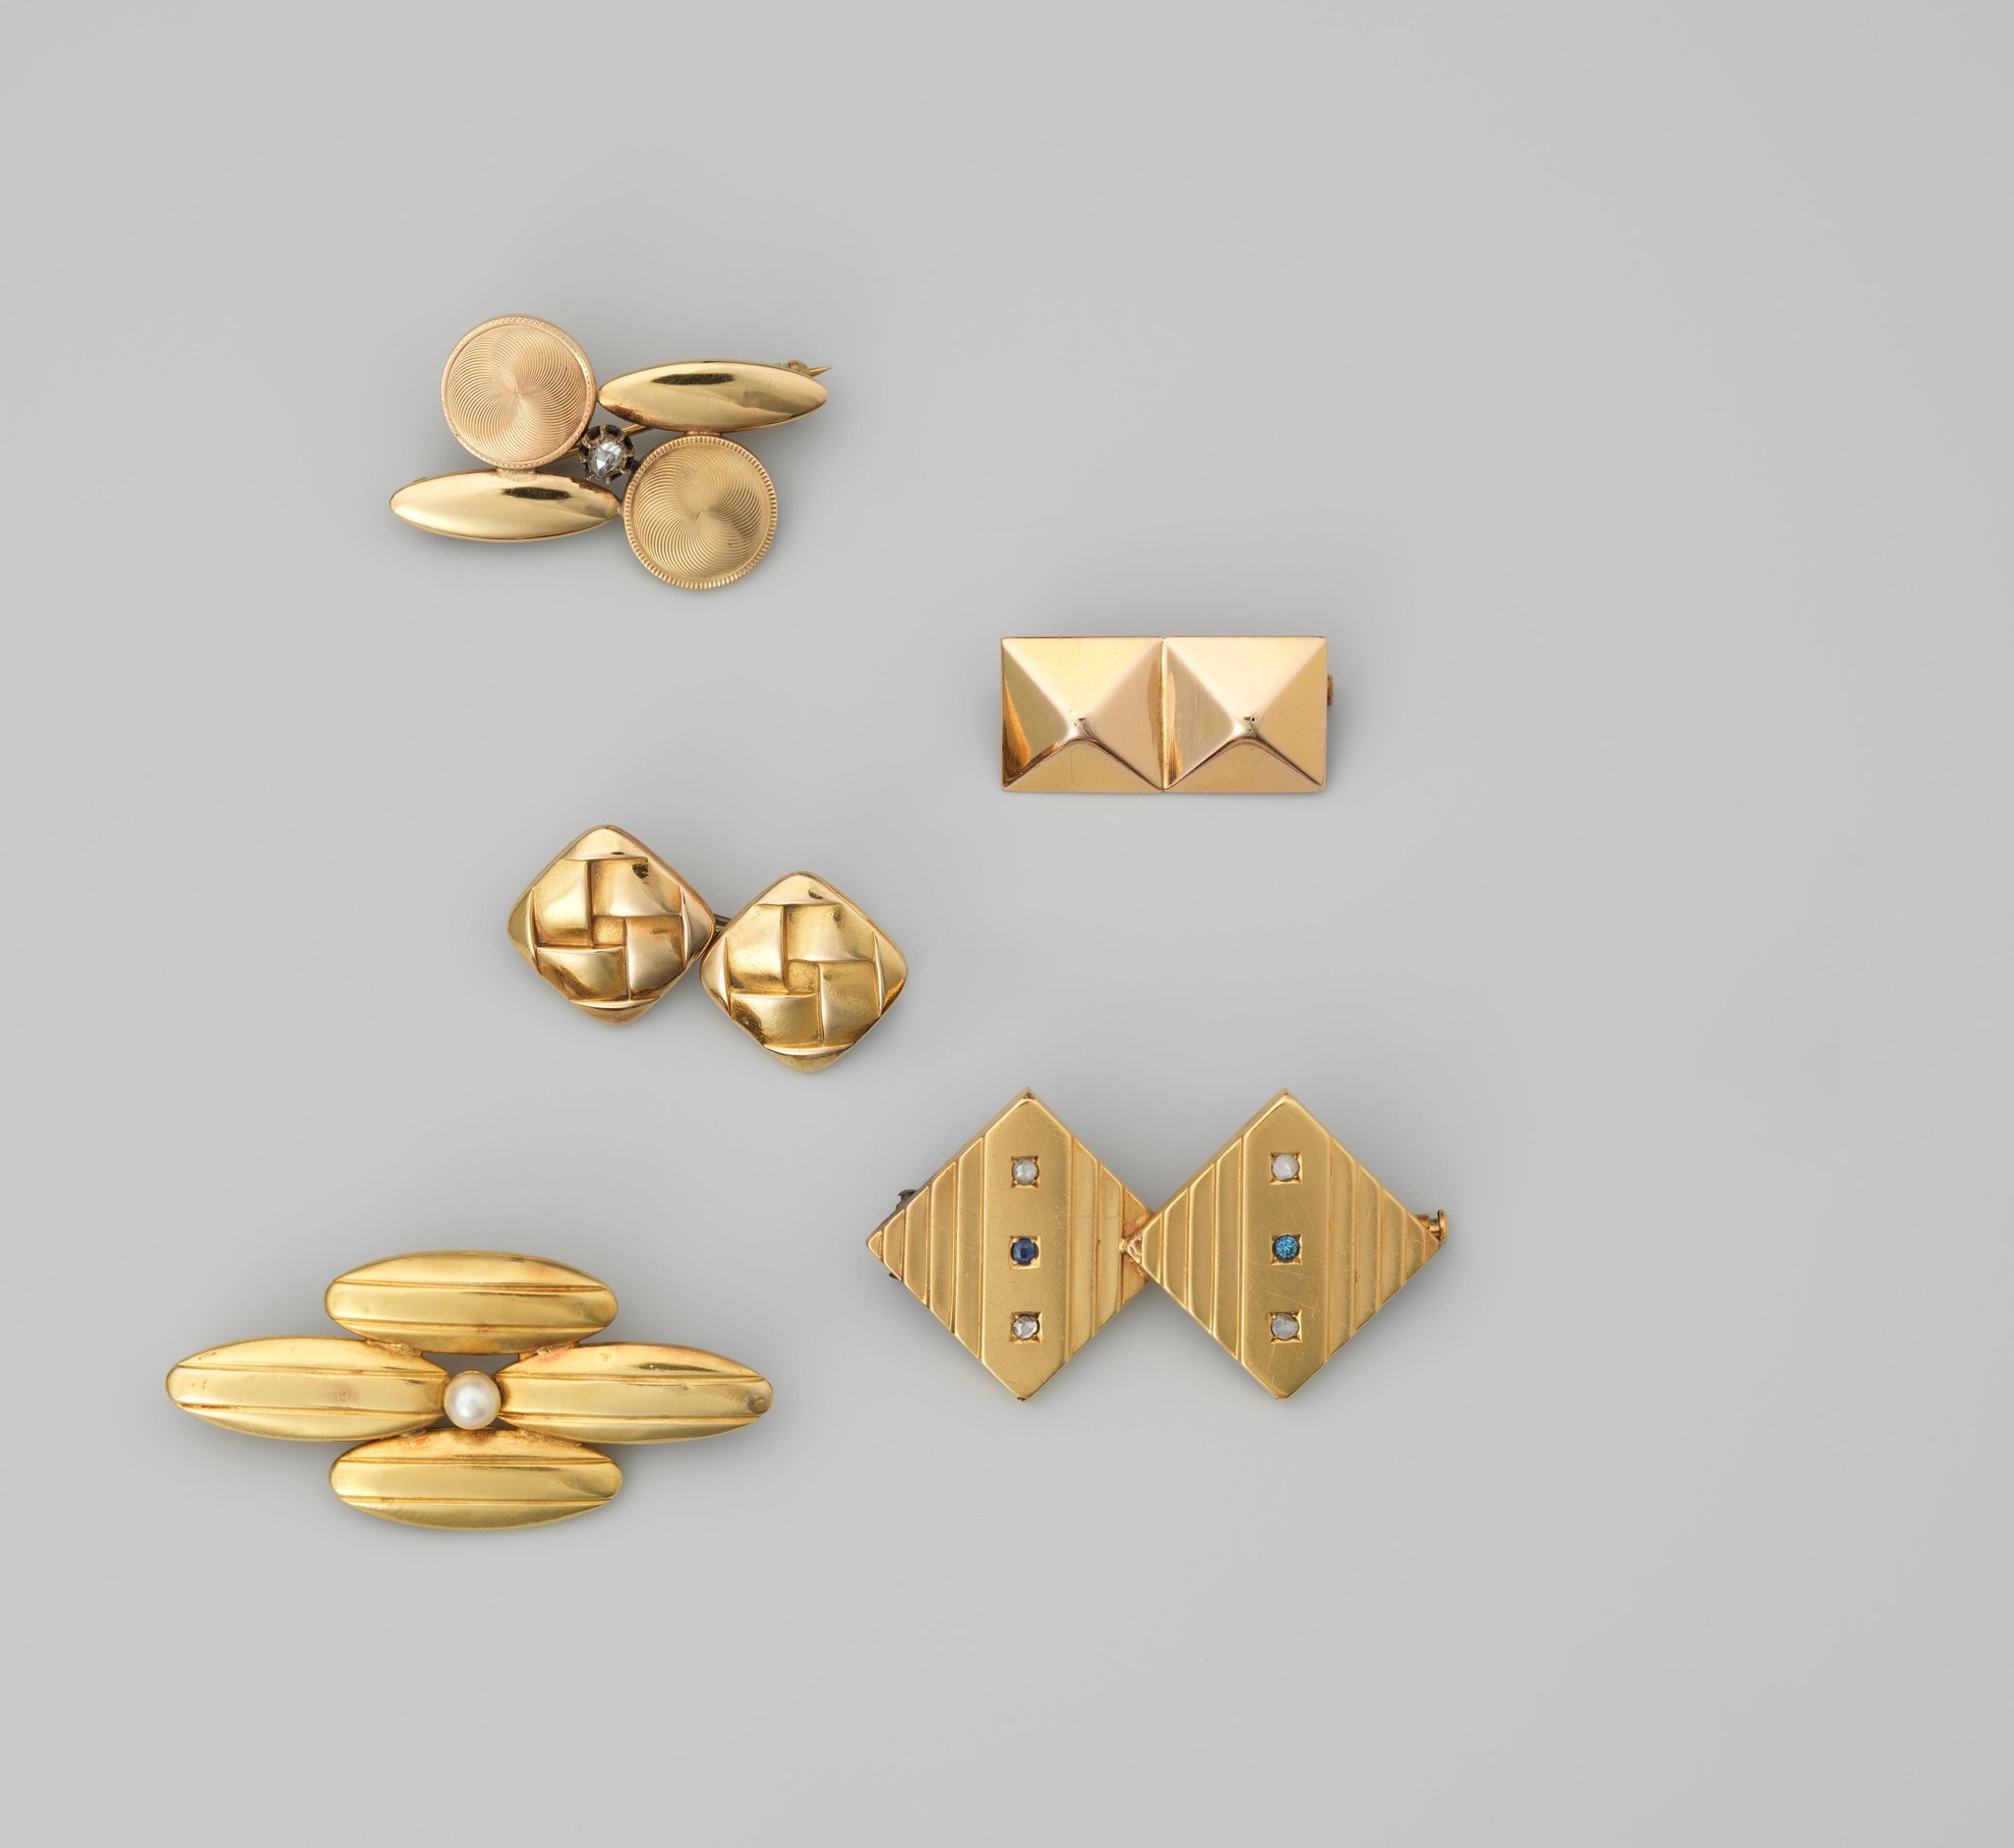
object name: brooch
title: Five Brooches Made of Cufflinks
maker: Anonymous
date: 1930-1960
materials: gold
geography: netherlands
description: Broche van goud van twee vierkante manchetknopen met een vlechtpatroon. De broche is voorzien van een haaksluiting en een veiligheidsspeldje.